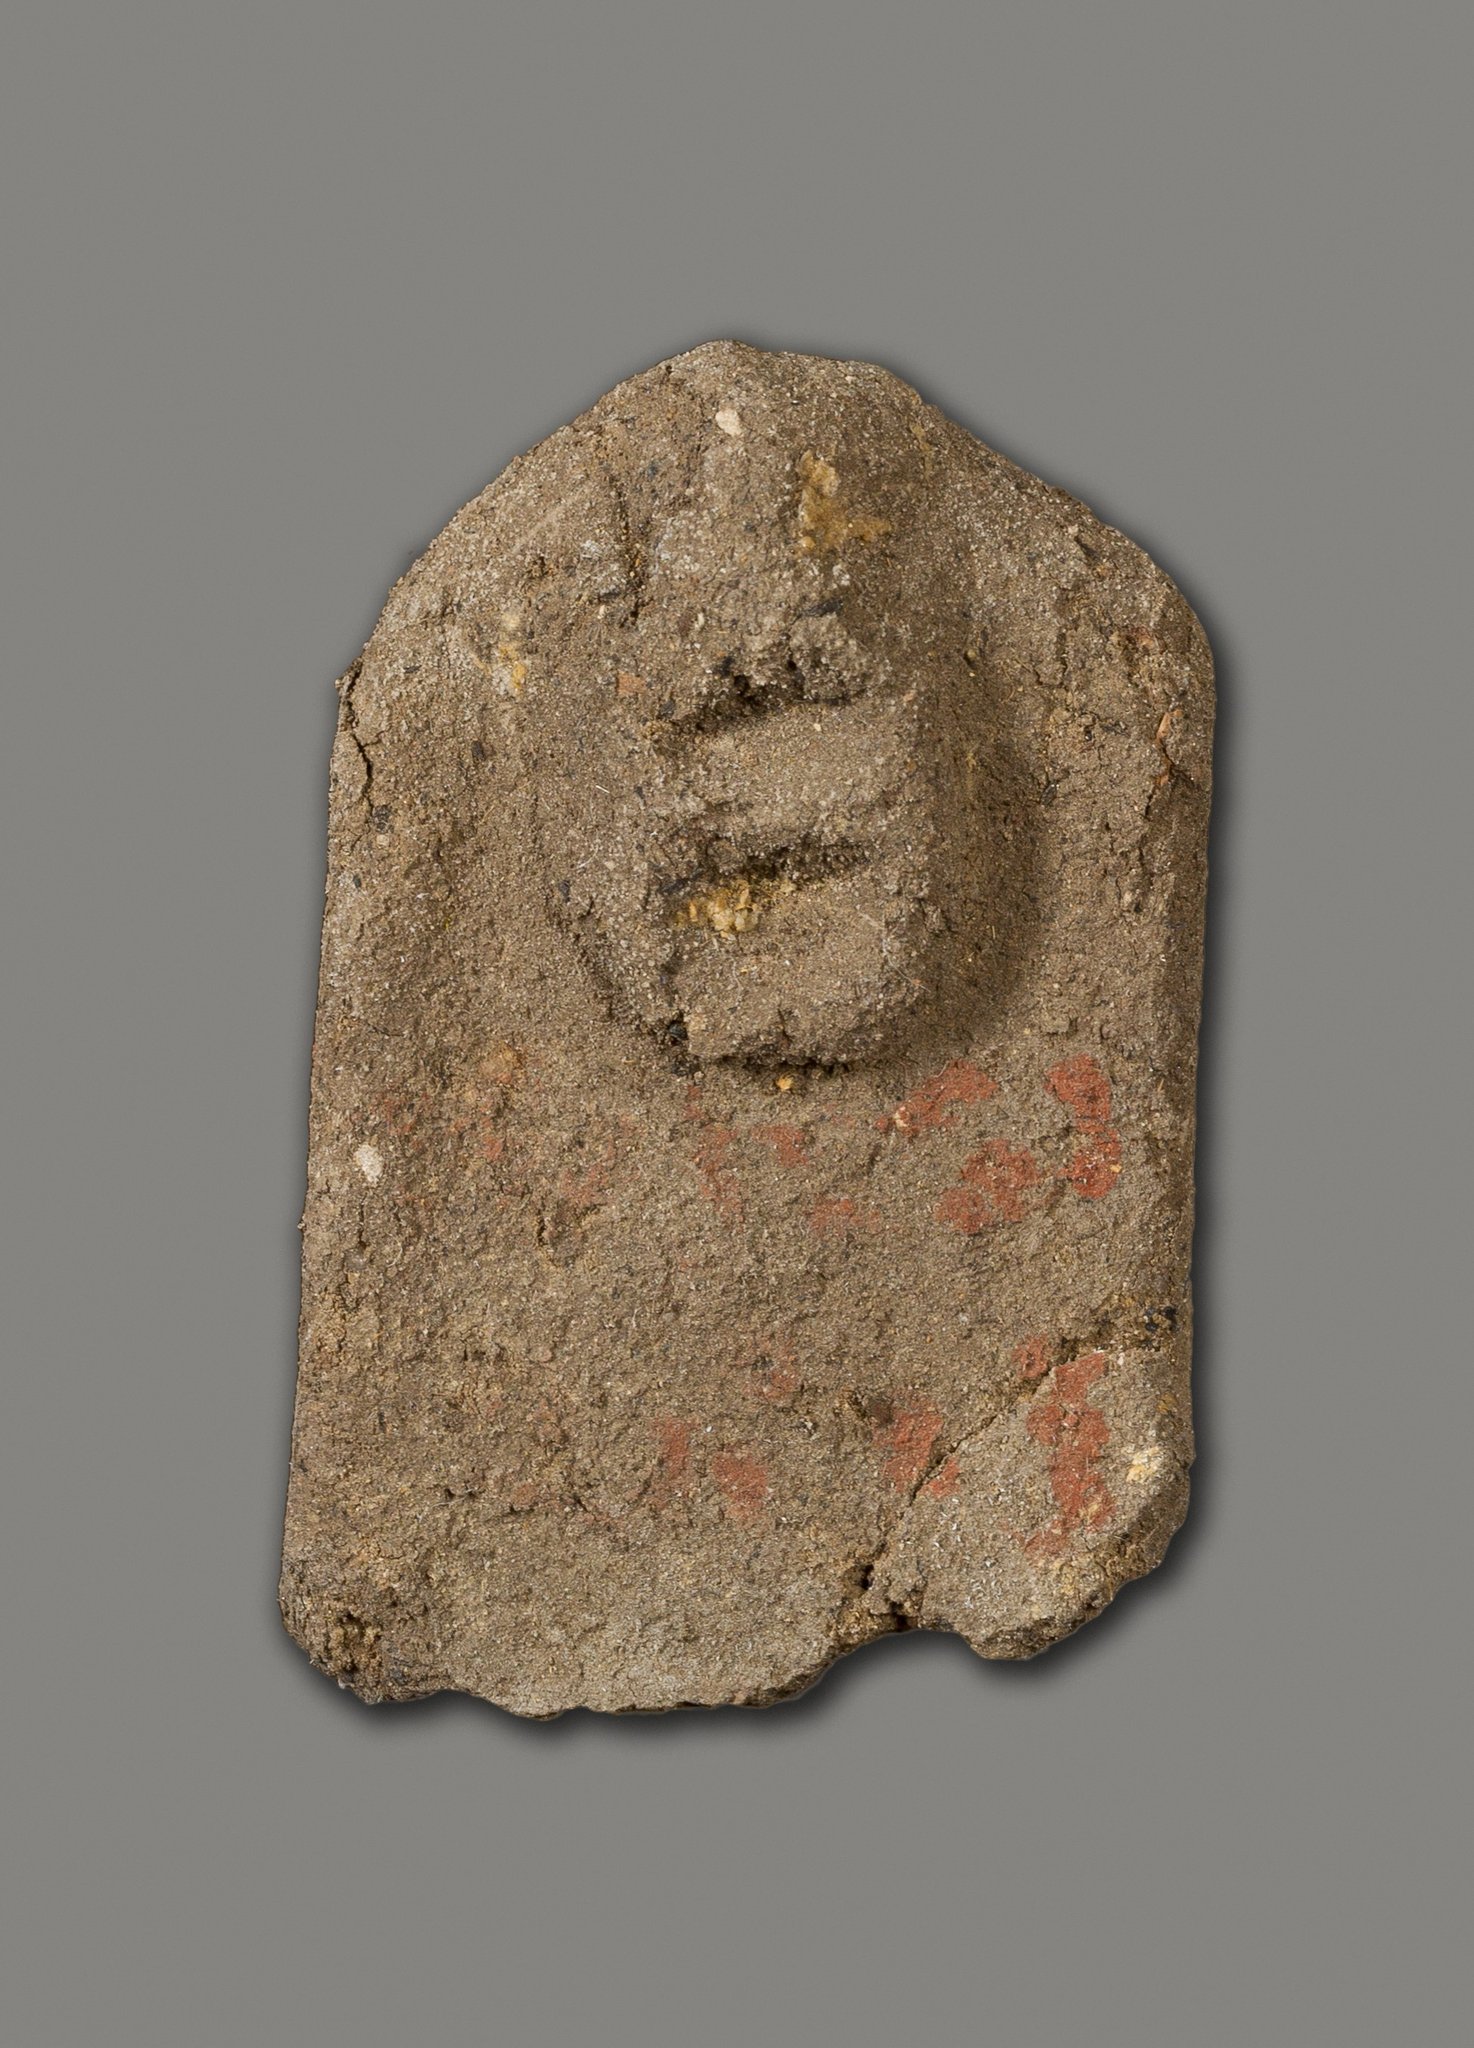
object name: figure, magical, execration, tablet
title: Magical Figure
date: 1802-1550 BCE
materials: clay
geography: egypt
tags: faces